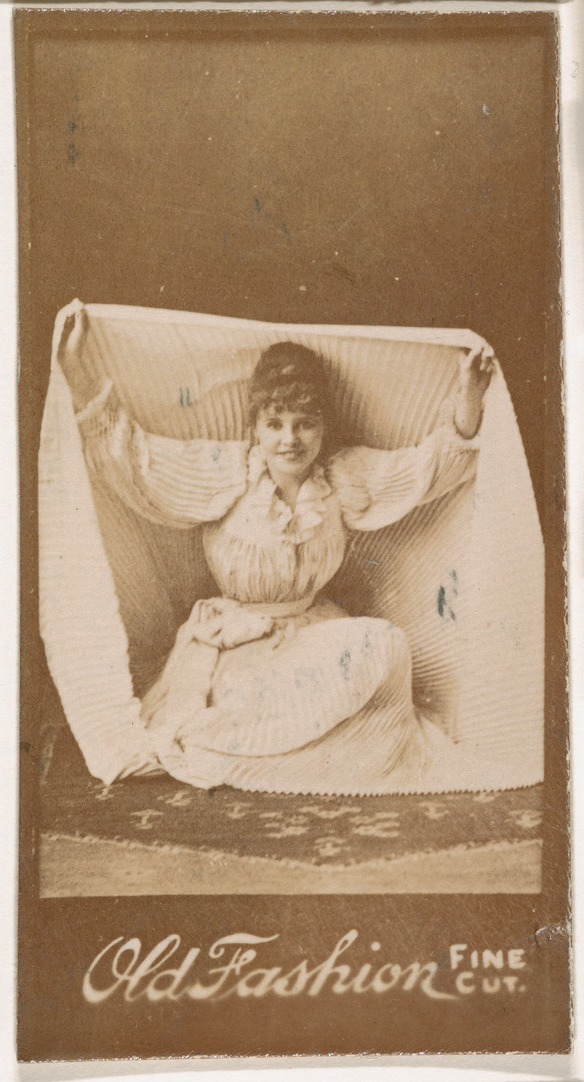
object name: photograph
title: Actress holding part of skirt above head, from the Actresses series (N664) promoting Old Fashion Fine Cut Tobacco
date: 1888-1890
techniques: albumen silver print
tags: portraits,women,actresses